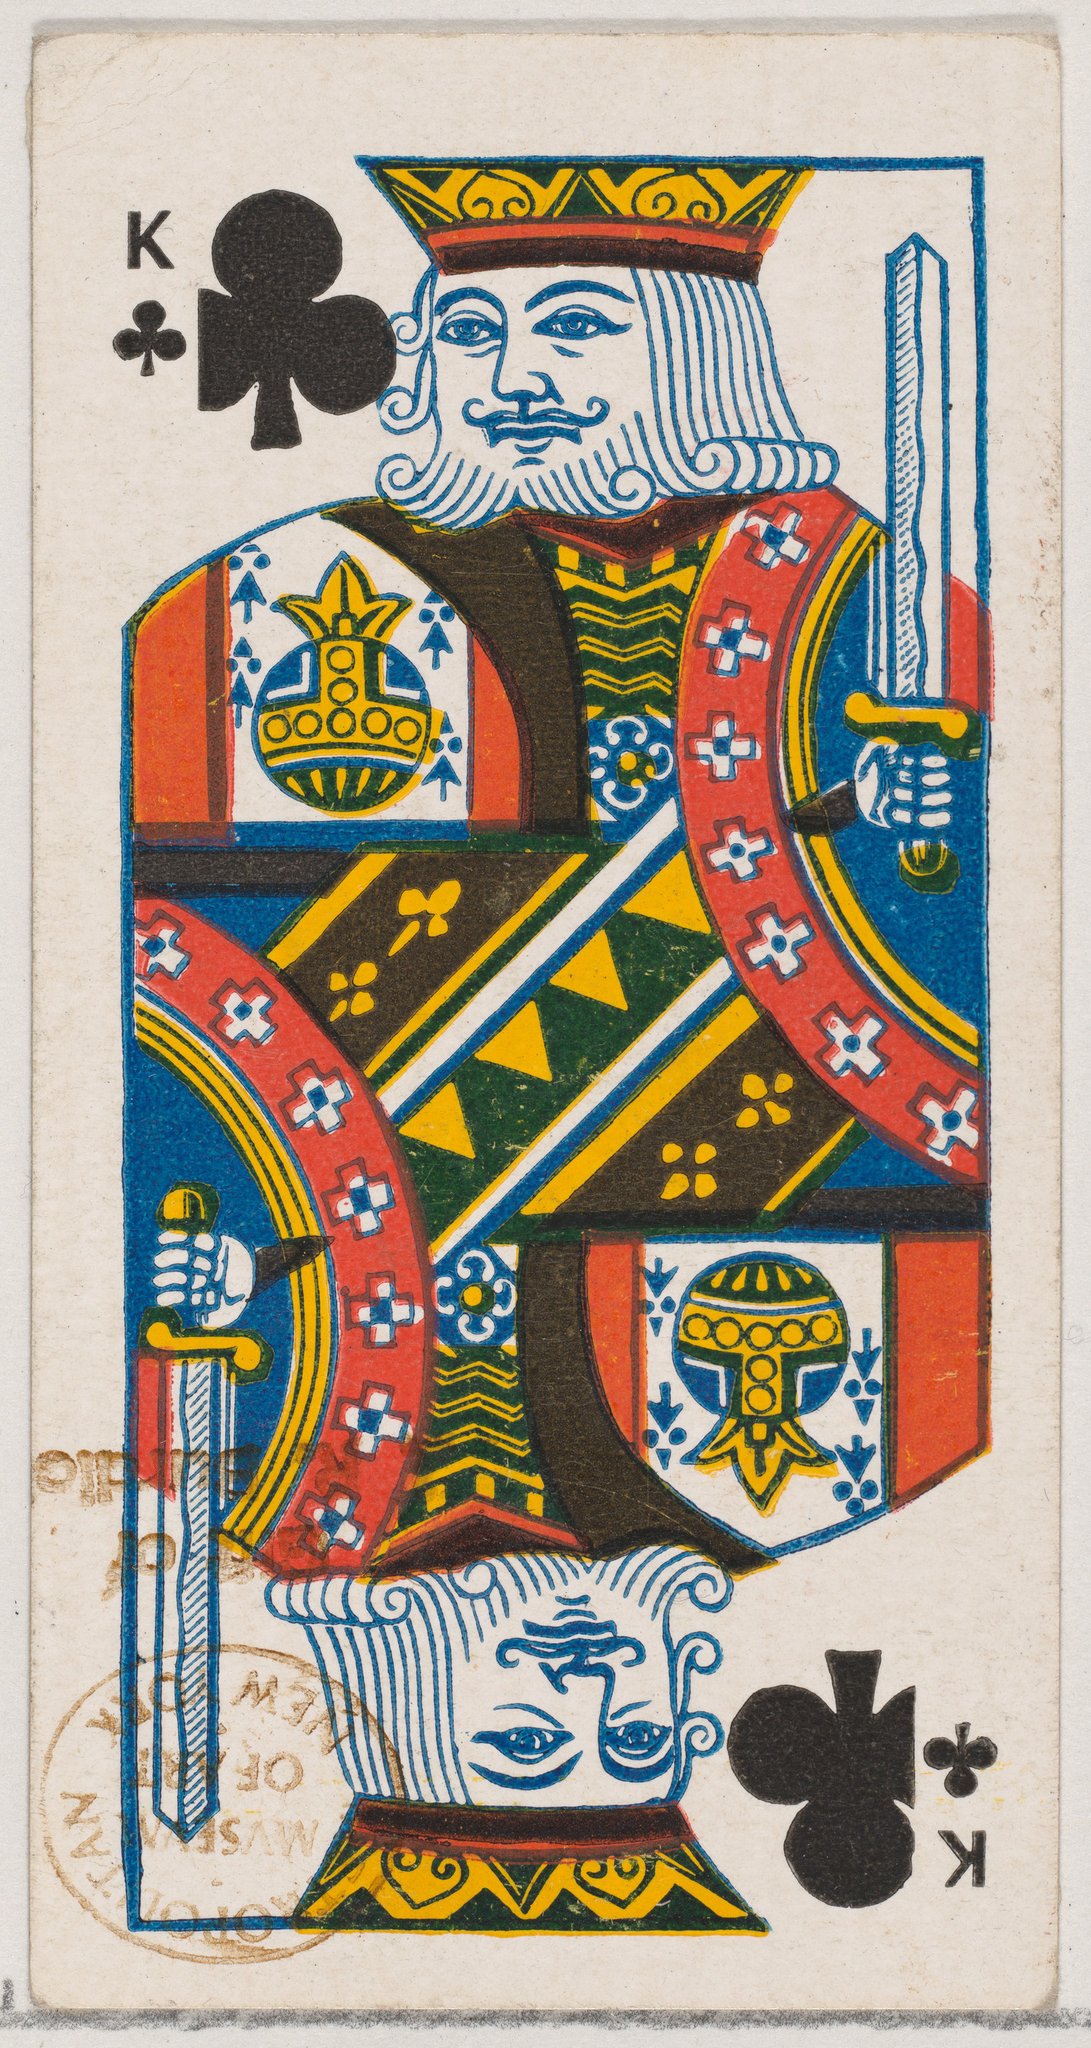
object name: print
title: King of Clubs (black), from the Playing Cards series (N84) for Duke brand cigarettes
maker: w. duke, sons & co.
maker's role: publisher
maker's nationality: american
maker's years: 1870-1920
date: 1888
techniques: color lithograph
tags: playing cards